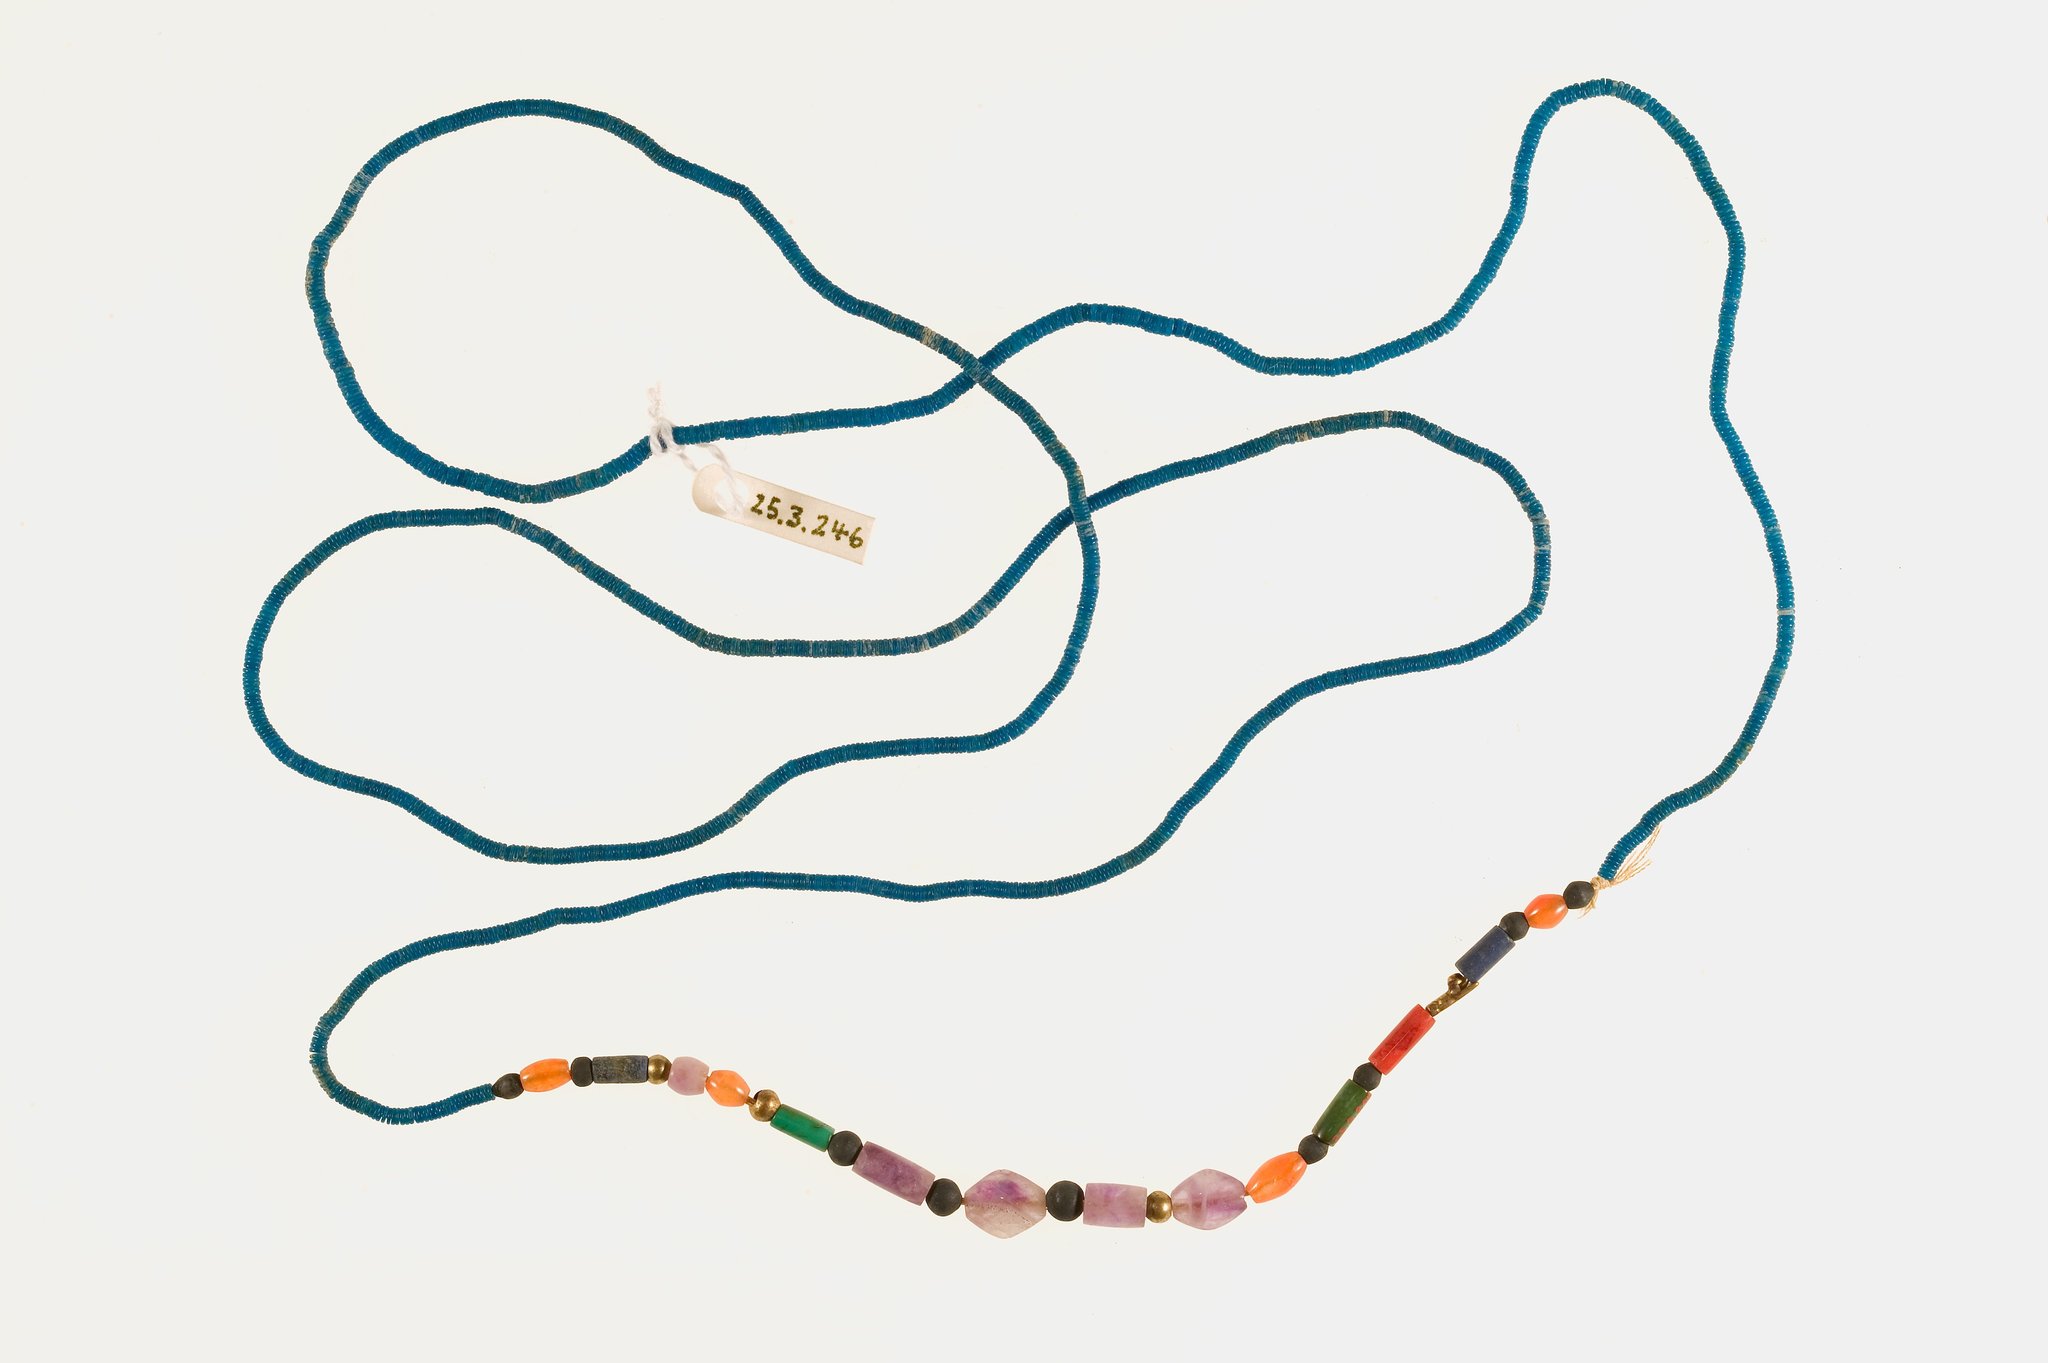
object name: necklace, queen neferu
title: Necklace of queen Neferu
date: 2051-2030 BCE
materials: faience, gold, silver, stone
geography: egypt